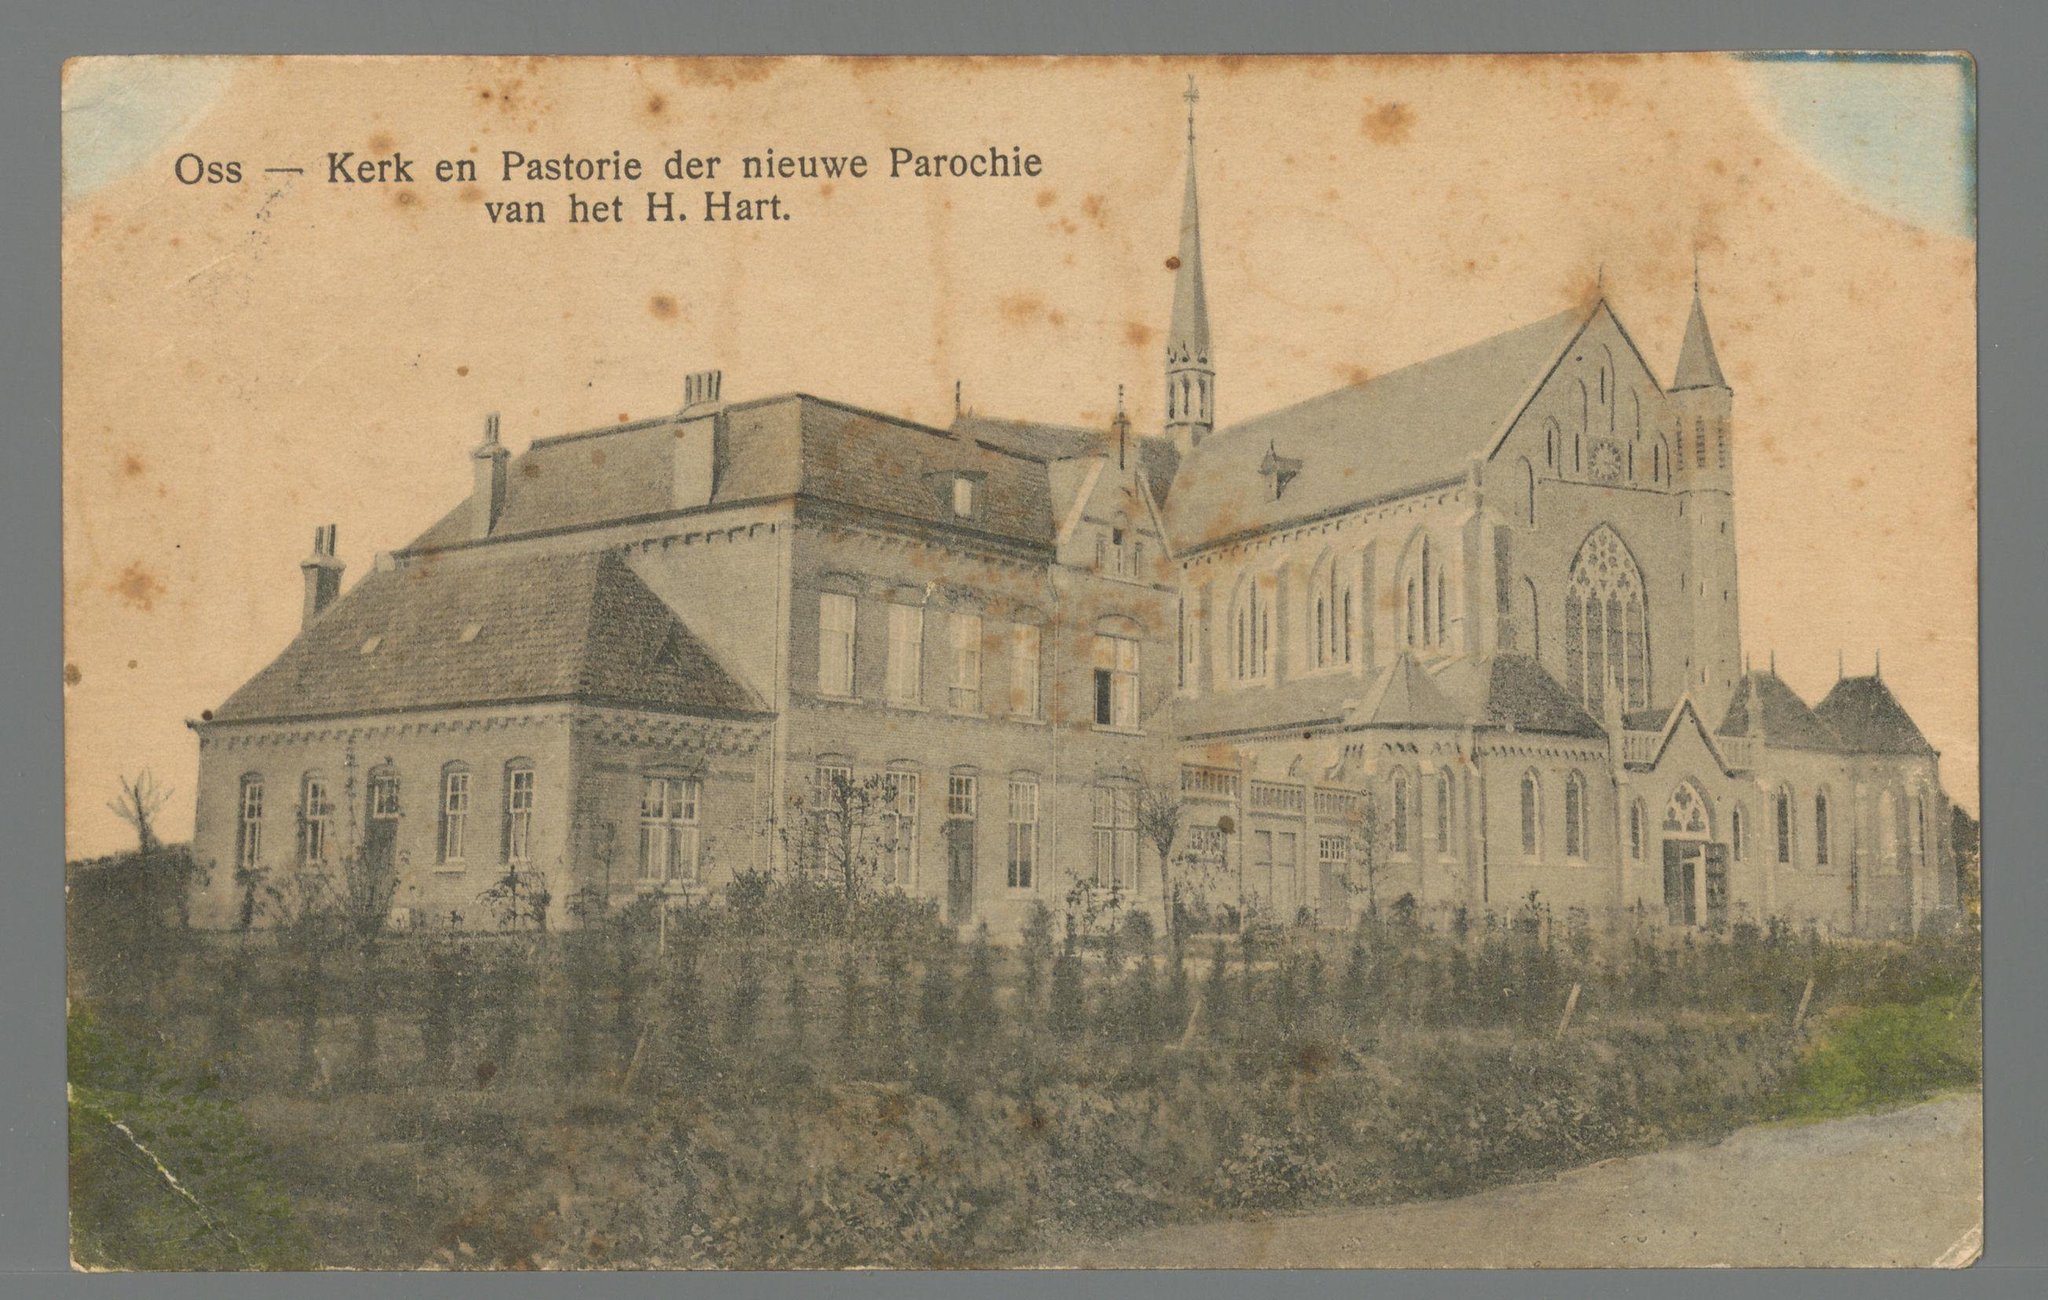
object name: photomechanical print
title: Oss - Kerk en pastorie der nieuwe Parochie van het H. Hart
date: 1921-1928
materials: cardboard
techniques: photograph, hand coloring, writing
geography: oss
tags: church (exterior)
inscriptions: poststempel, verso, gestempeld